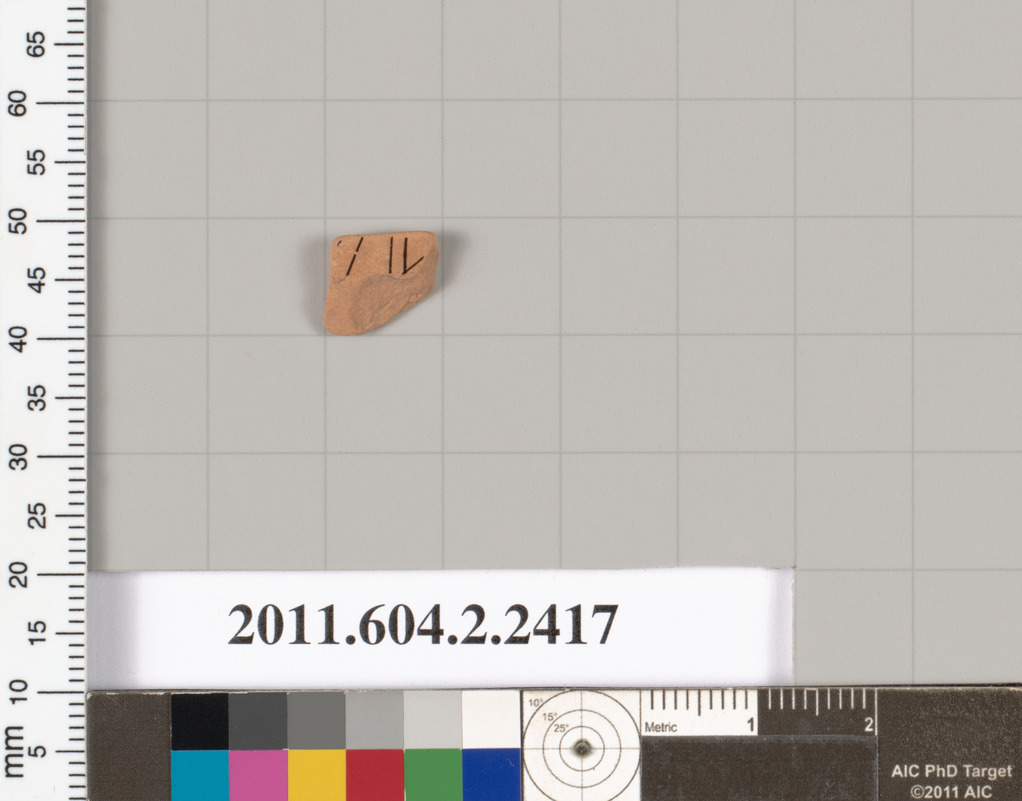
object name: undetermined shape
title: Terracotta fragment of an undetermined shape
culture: greek, attic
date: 490-470 BCE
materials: terracotta